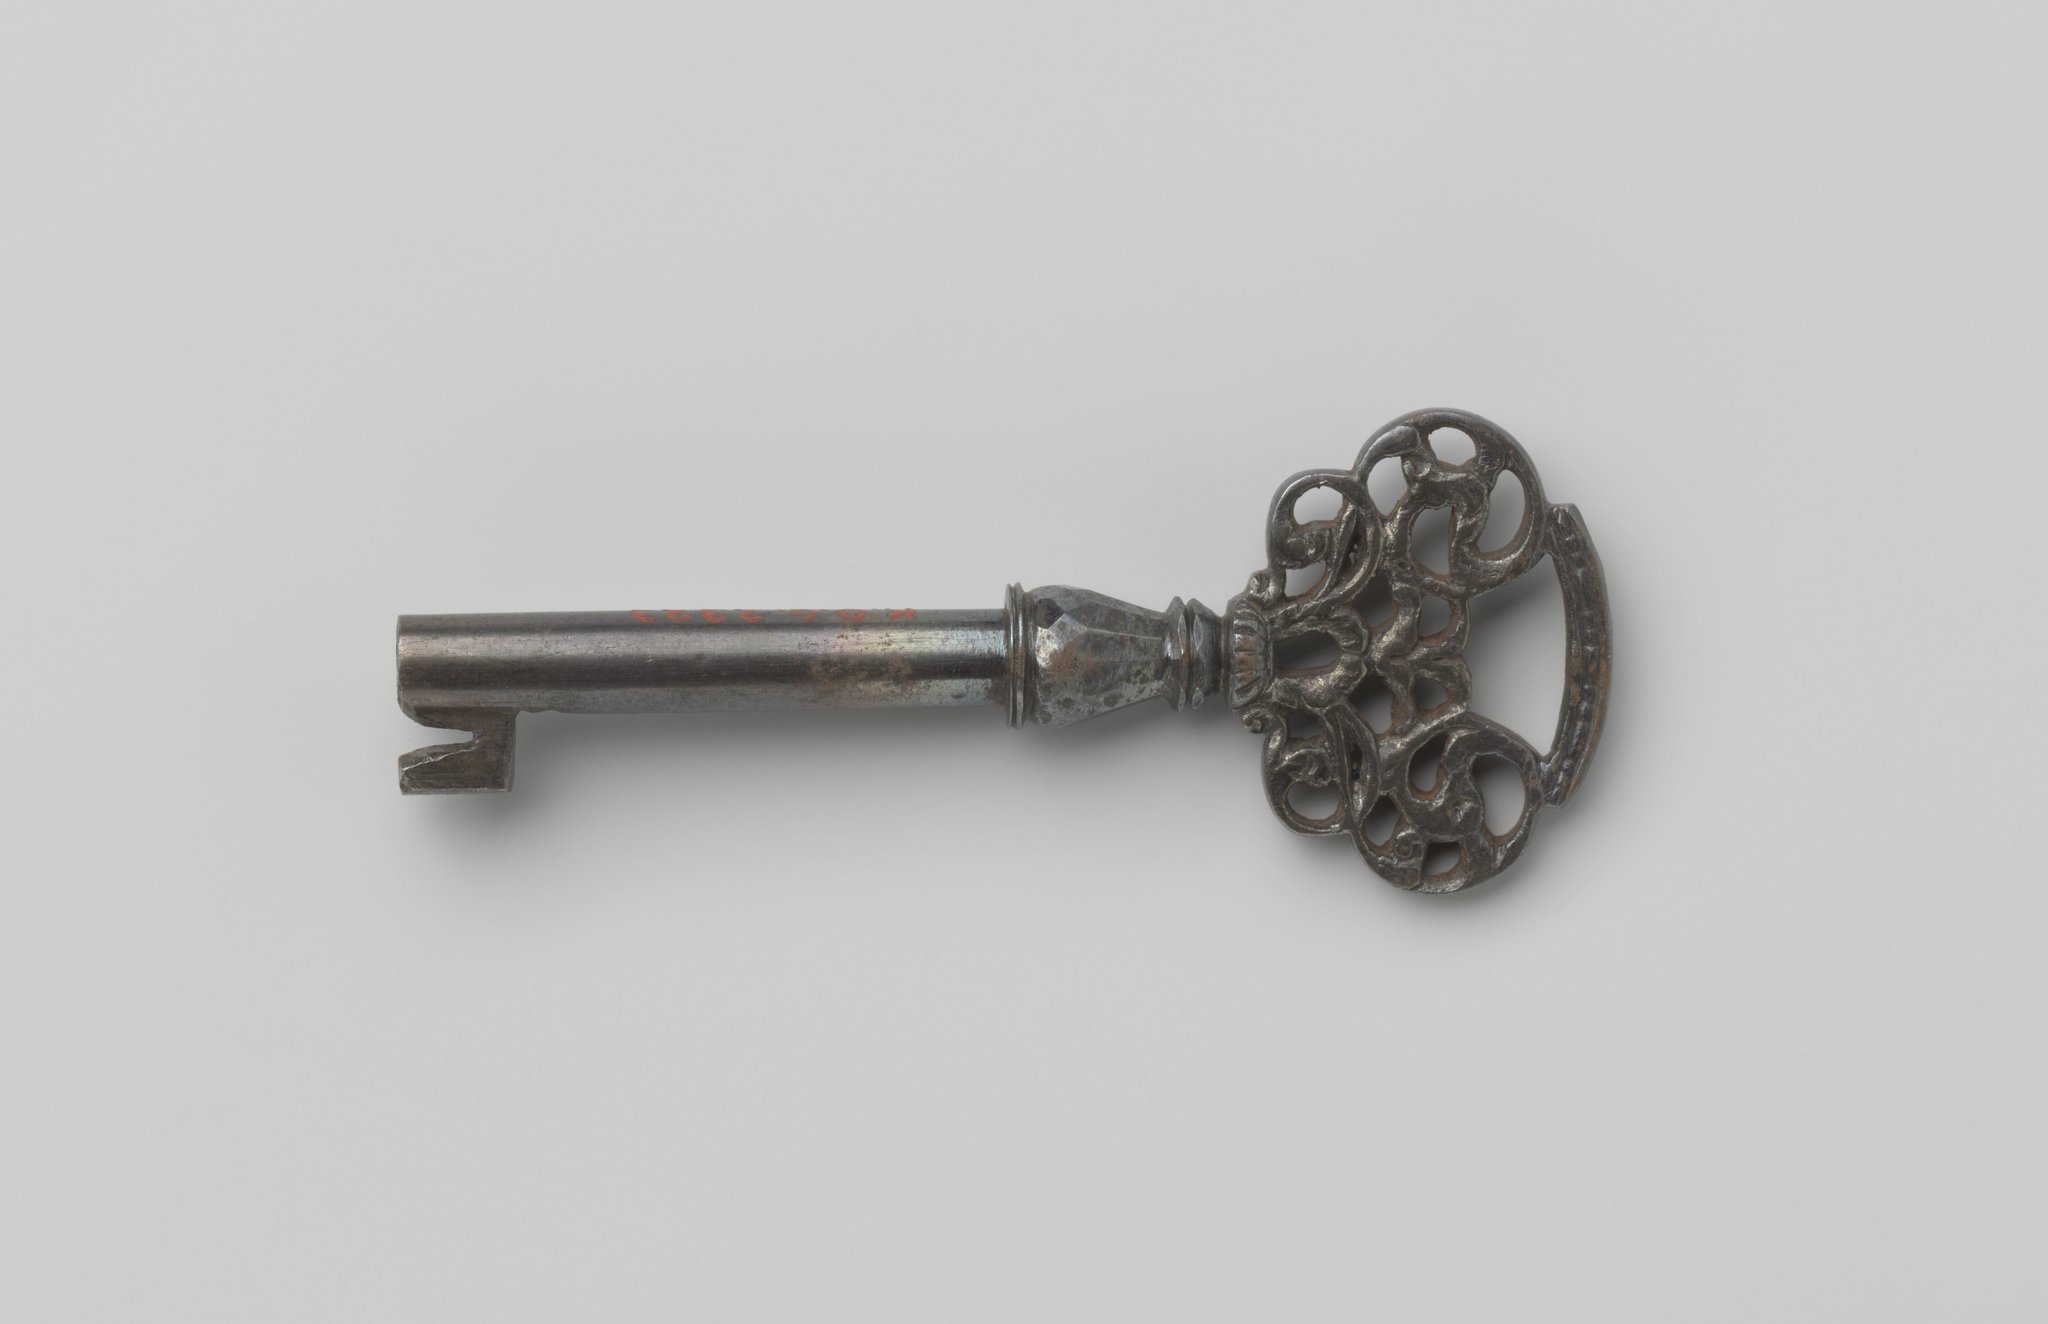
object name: pipe key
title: Pijpsleutel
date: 1700-1800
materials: iron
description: Pijpsleutel met ovale greep bestaande uit bladvoluten, boven afgedekt door een gebogen staafje. De sleutelborst is facetvormig.